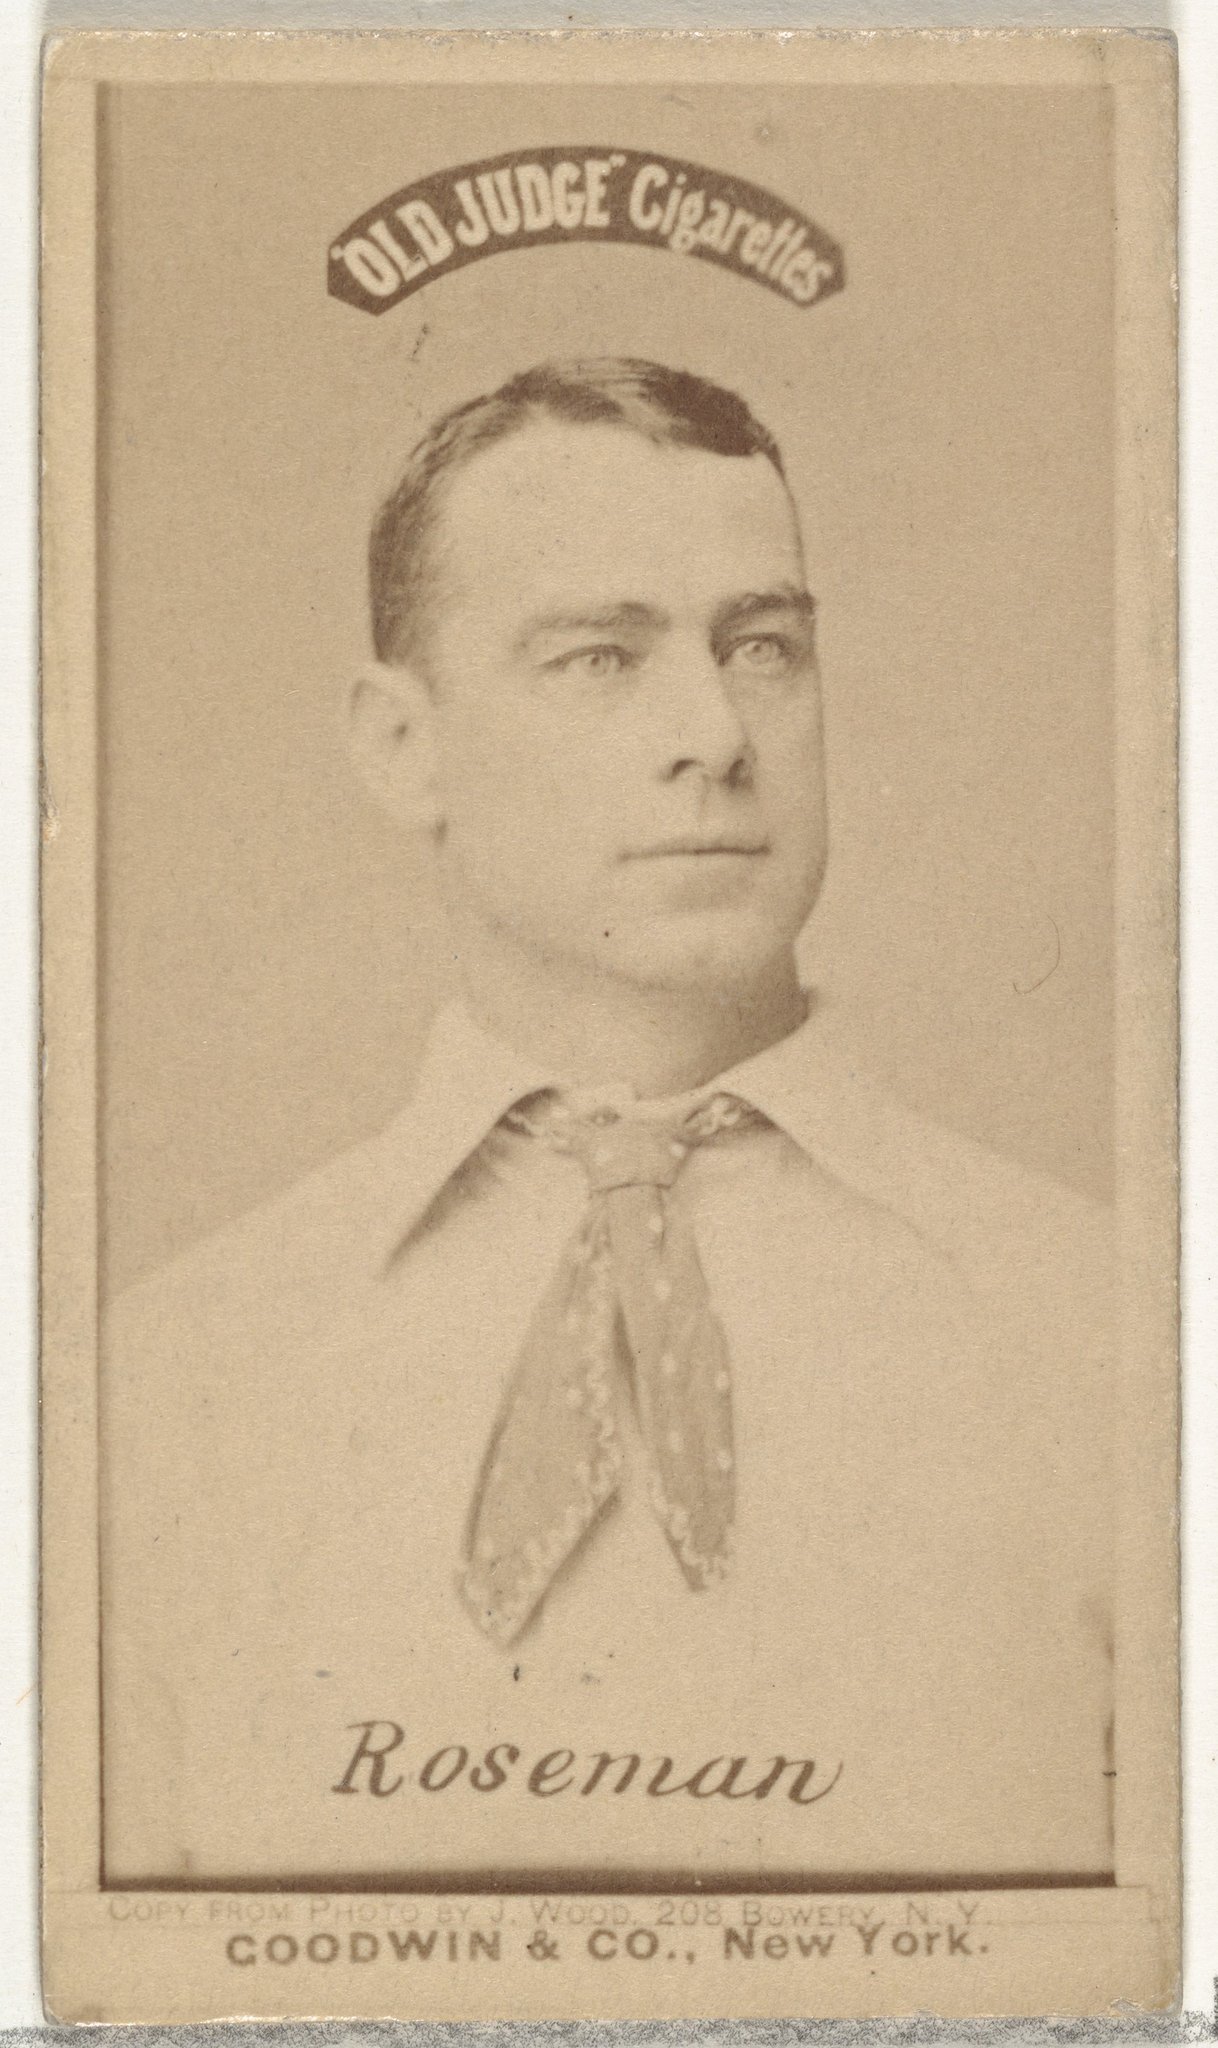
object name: baseball card, photograph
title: Roseman, from the Old Judge series (N172) for Old Judge Cigarettes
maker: goodwin & company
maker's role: publisher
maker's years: 1850-1950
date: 1887-1890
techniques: albumen silver print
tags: men,portraits,baseball,athletes